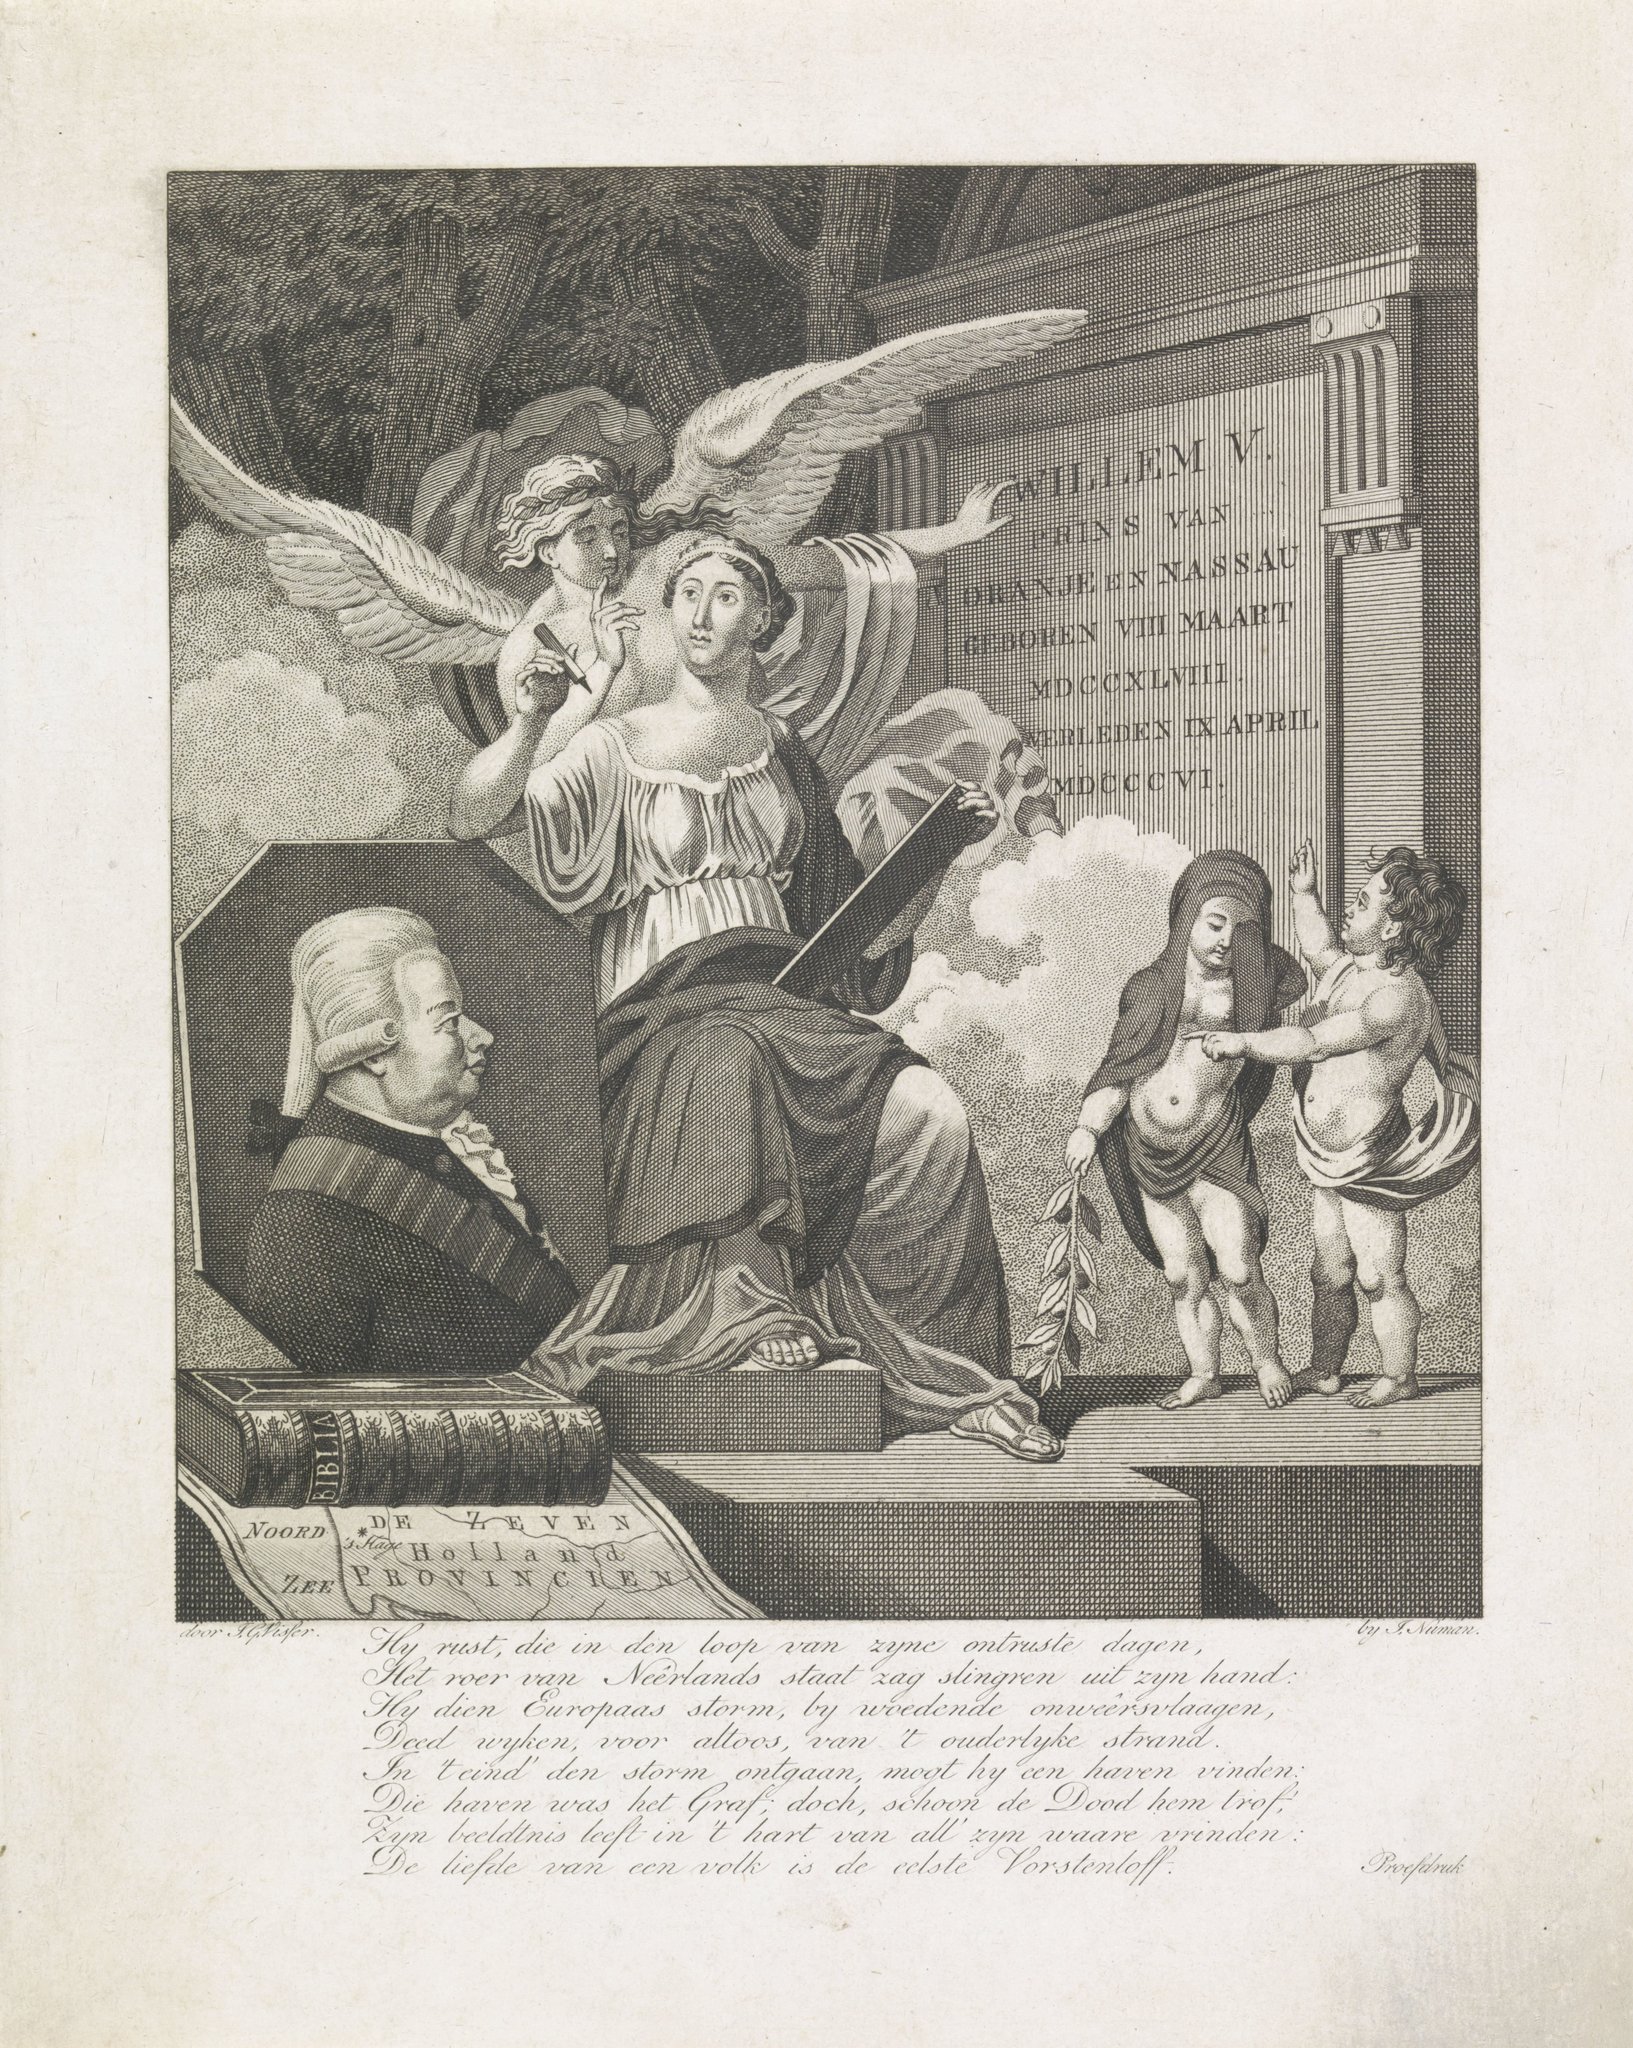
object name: print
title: Allegorisch grafmonument voor prins Willem V, 1806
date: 1806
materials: paper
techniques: engraving, etching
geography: netherlands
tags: william v (prince of orange), 'historia'; 'historia' (ripa), grave-building, monumental tomb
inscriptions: collector's mark: Lugt 2228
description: Allegorisch grafmonument voor prins Willem V, overleden op 9 april 1806. Bij de tombe van de prins schrijft de Historia geschiedenis. Een genius inspireert haar. Linksonder een portret van de prins in profiel naar rechts, hierbij een Bijbel en een kaart van de zeven provincieën. Bij de tombe staan twee kinderen. In de marge een vers van acht regels.